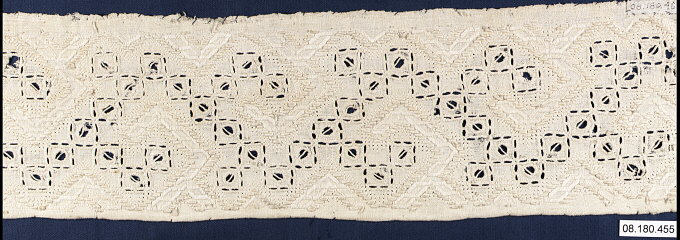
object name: border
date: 1501-1600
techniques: embroidery